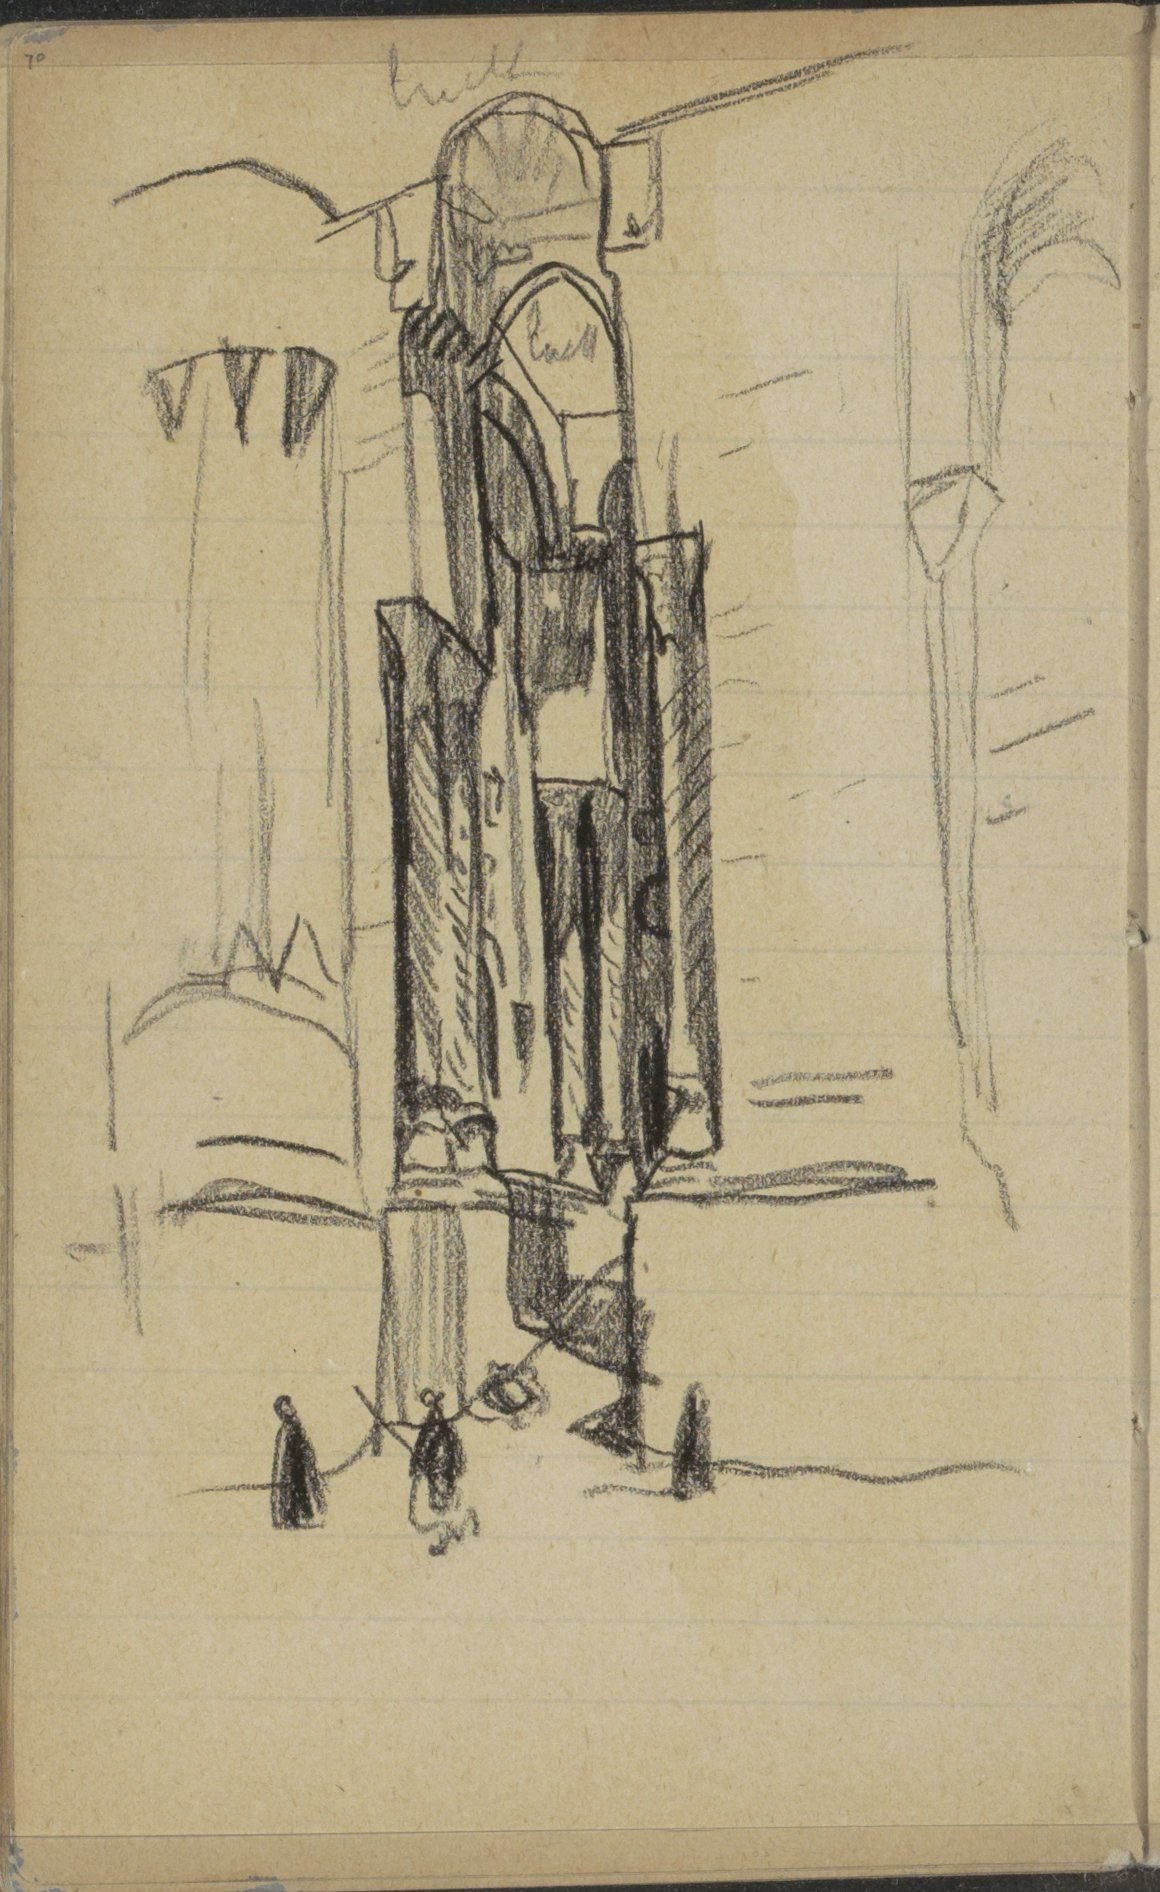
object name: sketchbook leaf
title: Figuren bij de voorgevel van een gebouw, mogelijk een moskee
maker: marius bauer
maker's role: draughtsman, print maker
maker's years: 1867-1932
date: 1894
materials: chalk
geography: cairo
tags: façade (of house or building), street (+ city(-scape) with figures, staffage)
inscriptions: kleurnotitie, handgeschreven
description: In de voorgevel lijkt een doorgang te zitten. Pagina 70 uit een schetsboek met 48 bladen.